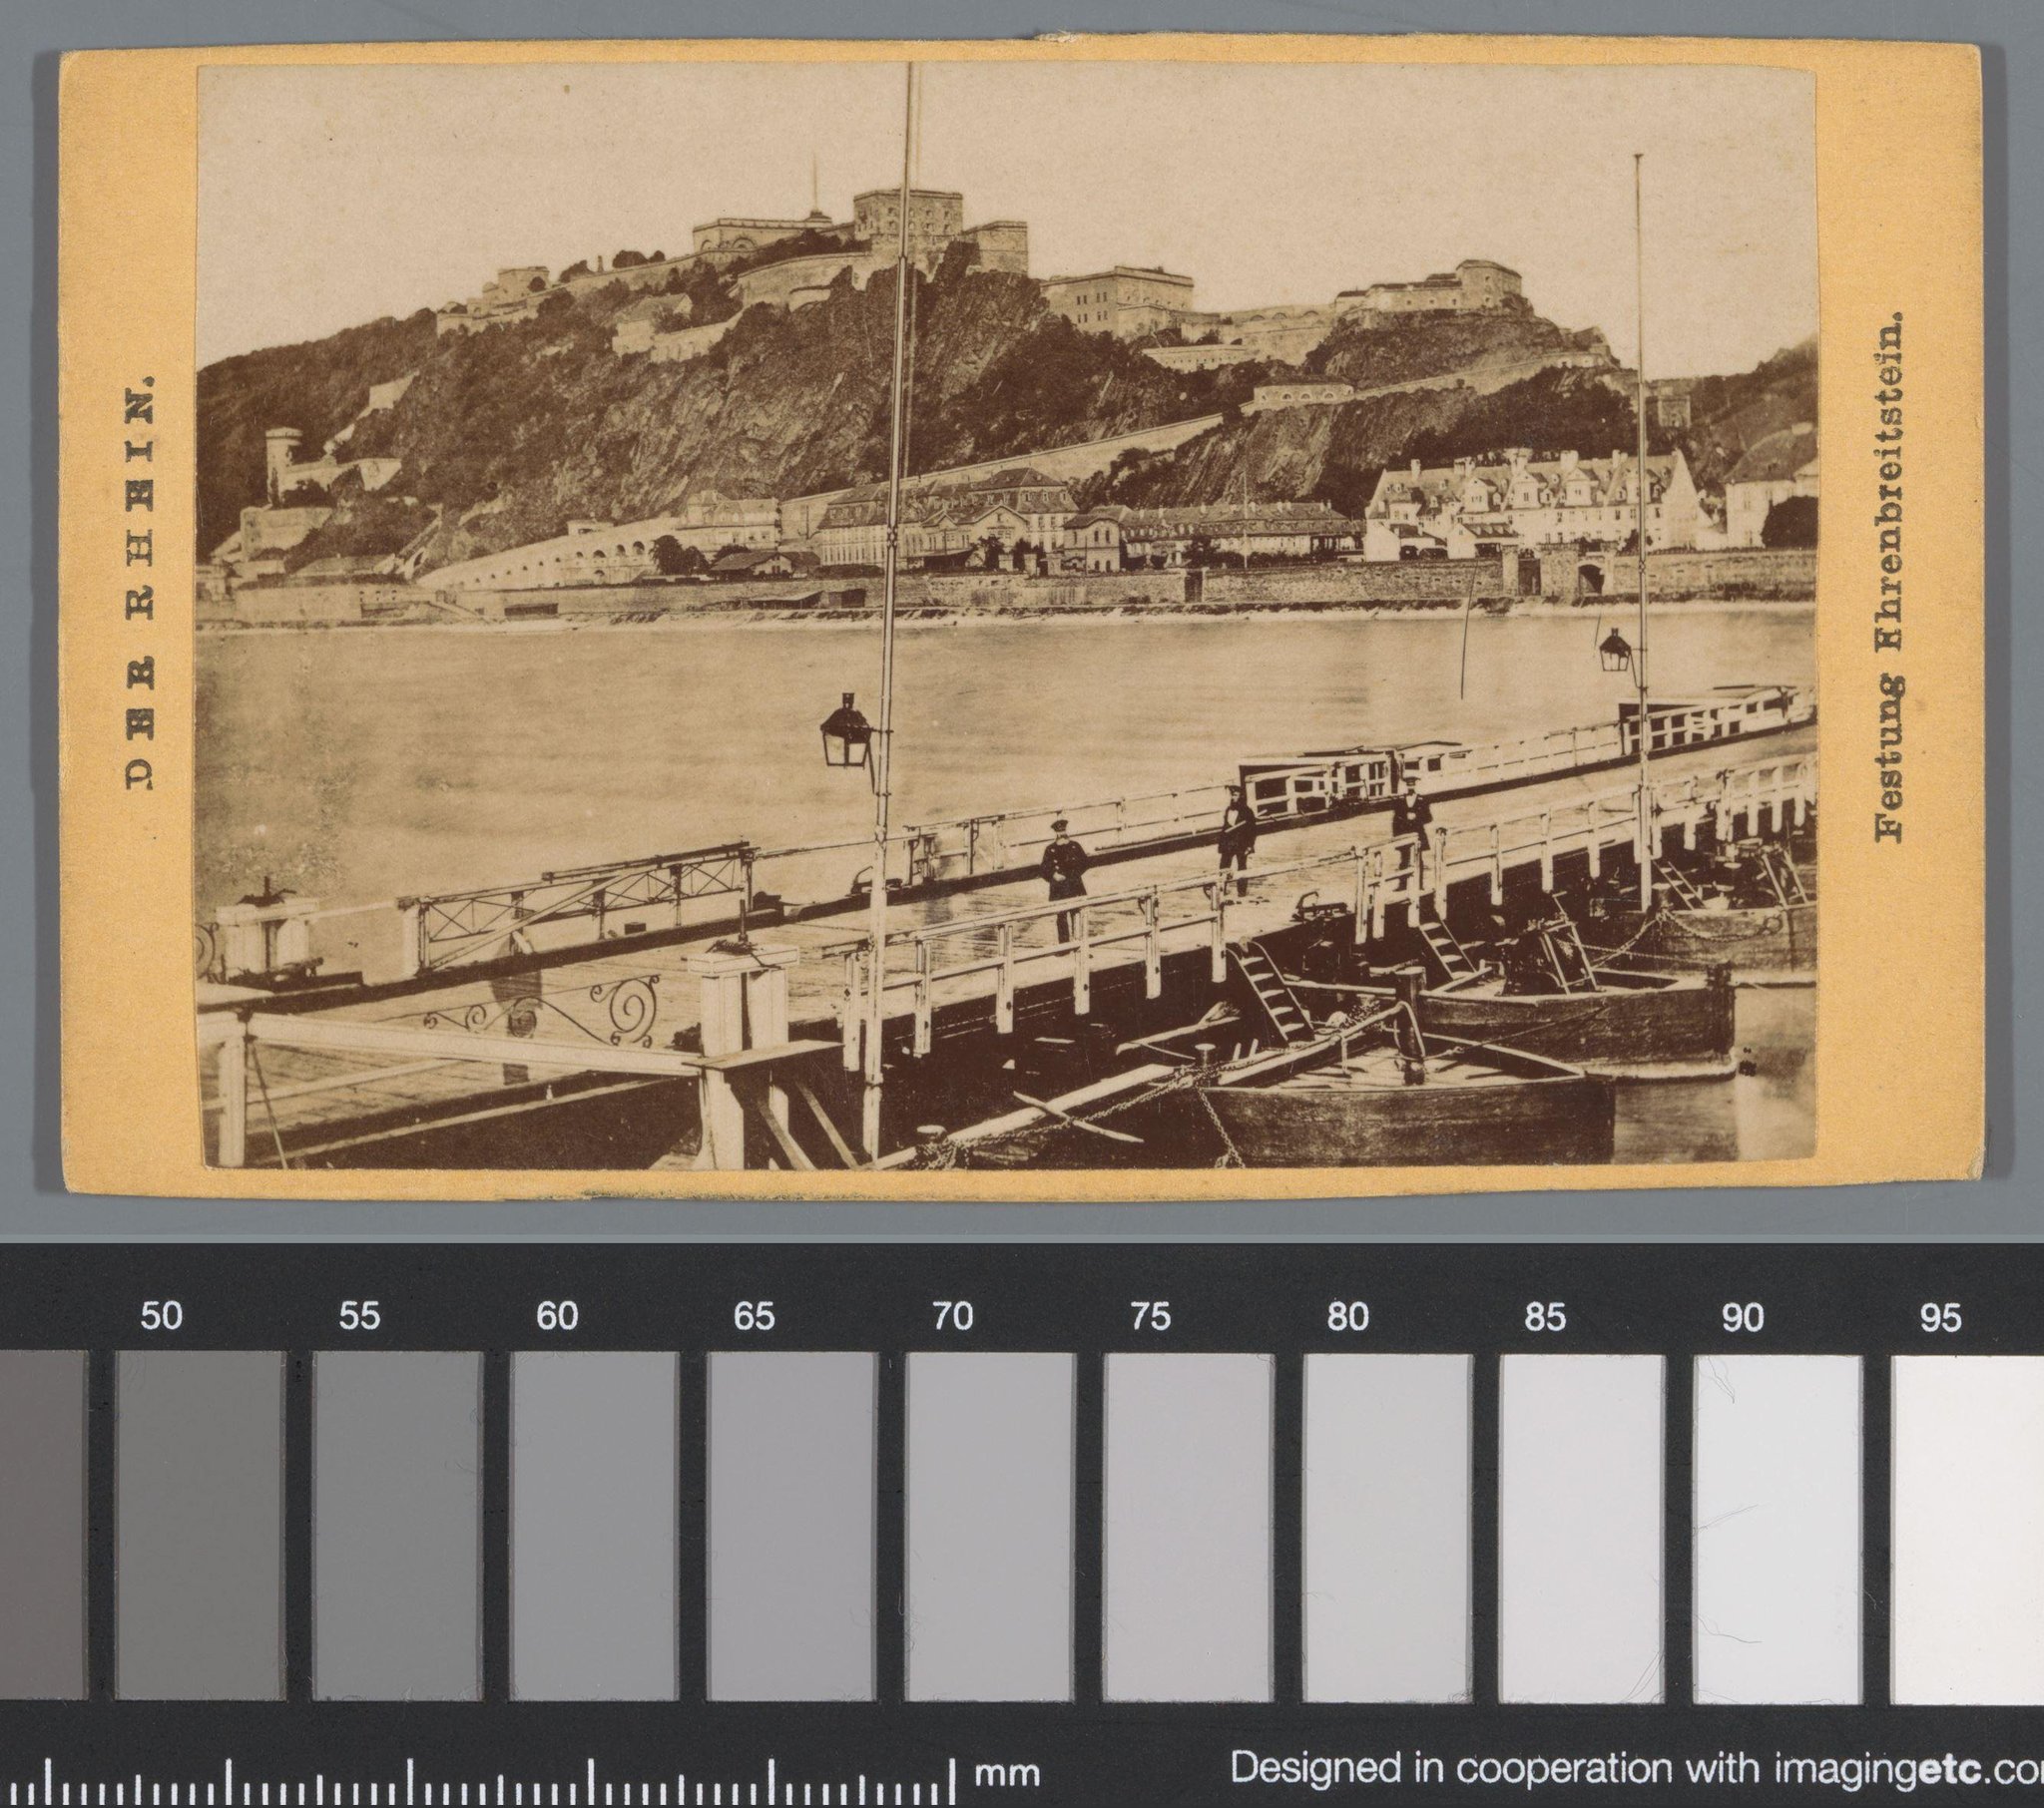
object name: carte de visite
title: Der Rhein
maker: Anonymous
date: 1860-1875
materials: cardboard, paper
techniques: albumen print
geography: koblenz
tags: landscape with tower or castle, pontoon bridge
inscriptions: inscription: ‘COBLENZ’